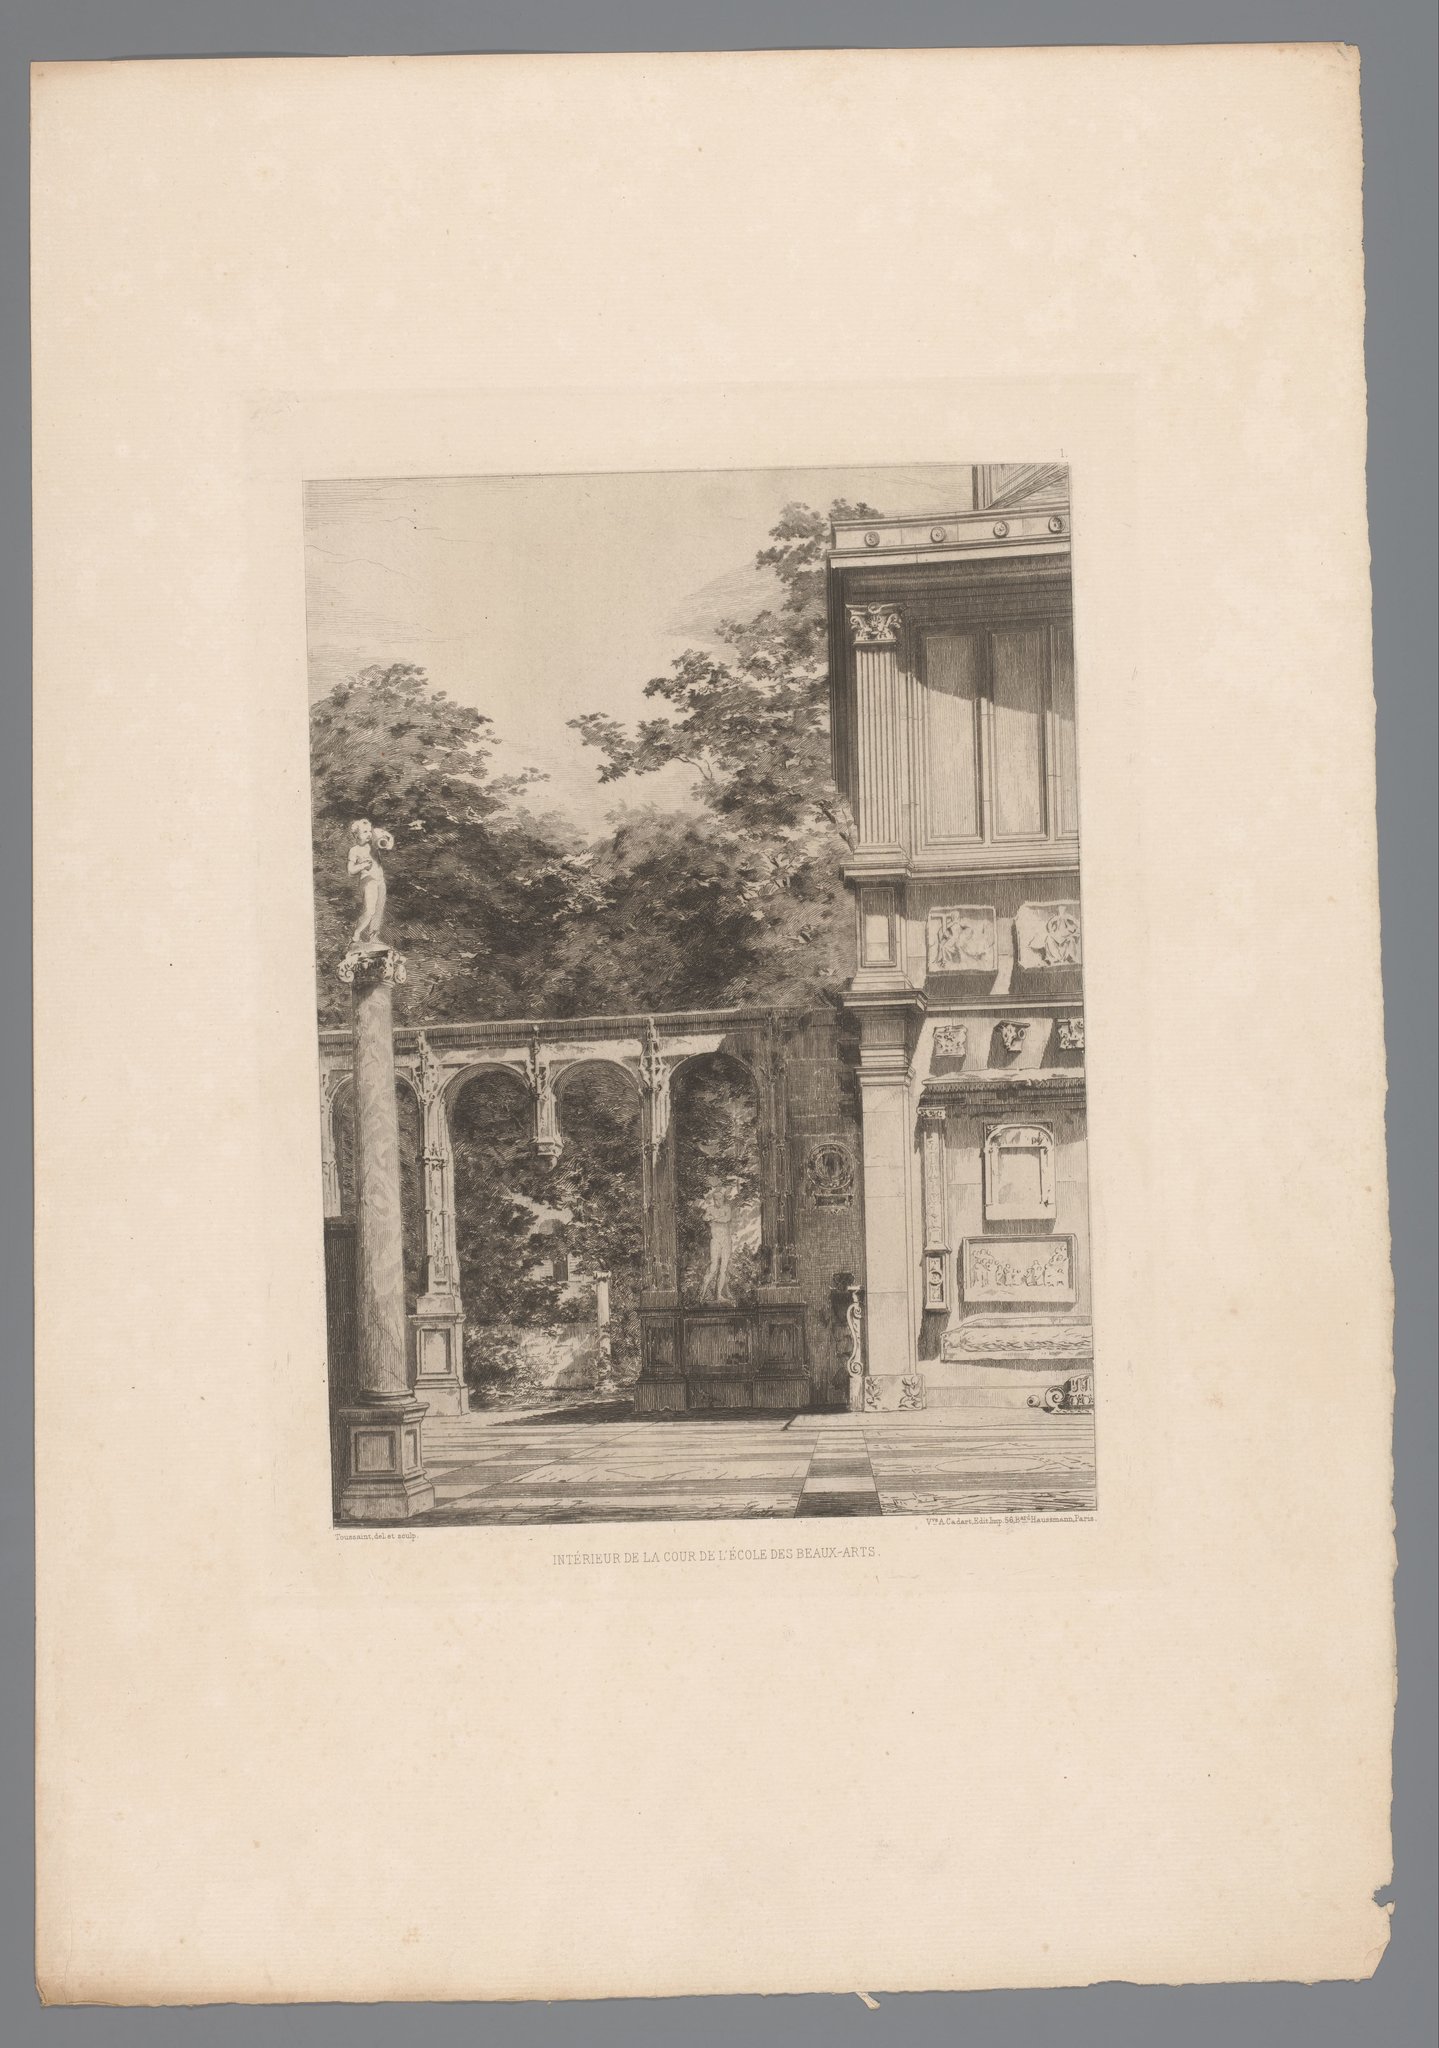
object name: print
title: Intérieur de la cour de l'École des Beaux-Arts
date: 1876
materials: paper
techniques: drypoint, etching, intaglio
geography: paris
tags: courtyard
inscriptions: collector's mark: Lugt 2760, collector's mark: Lugt 2228, collector's mark: ‘AFE v S’, watermark